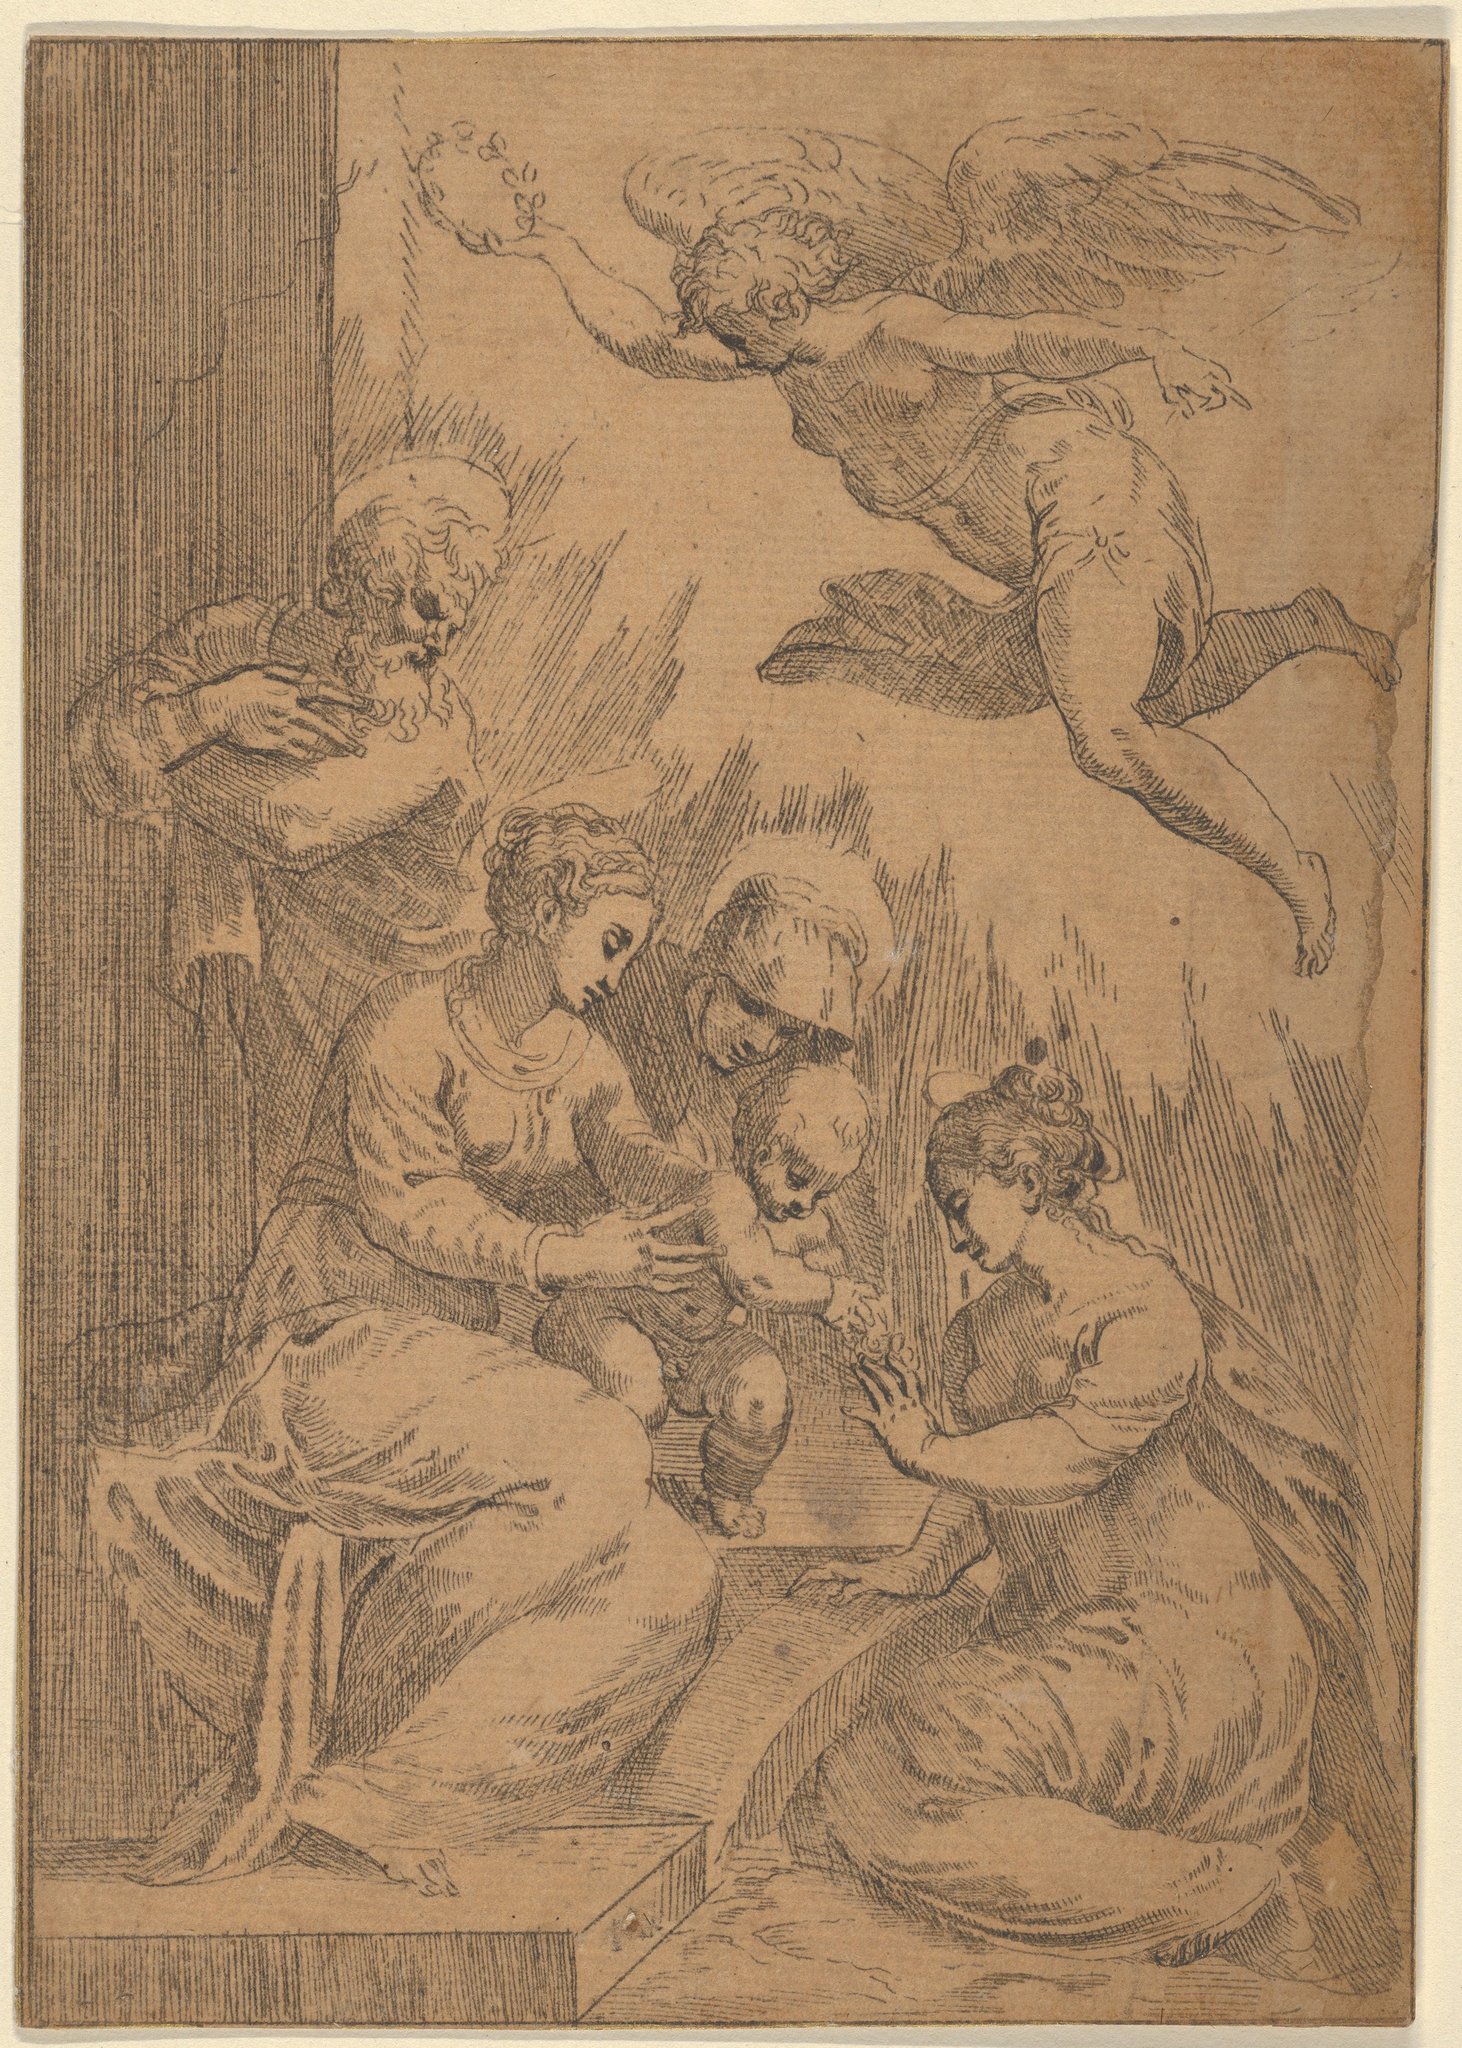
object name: print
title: The Mystic Marriage of St. Catherine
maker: marco angolo del moro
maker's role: artist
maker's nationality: italian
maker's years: 1537-1586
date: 1501-1600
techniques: etching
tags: infants,men,women,angels